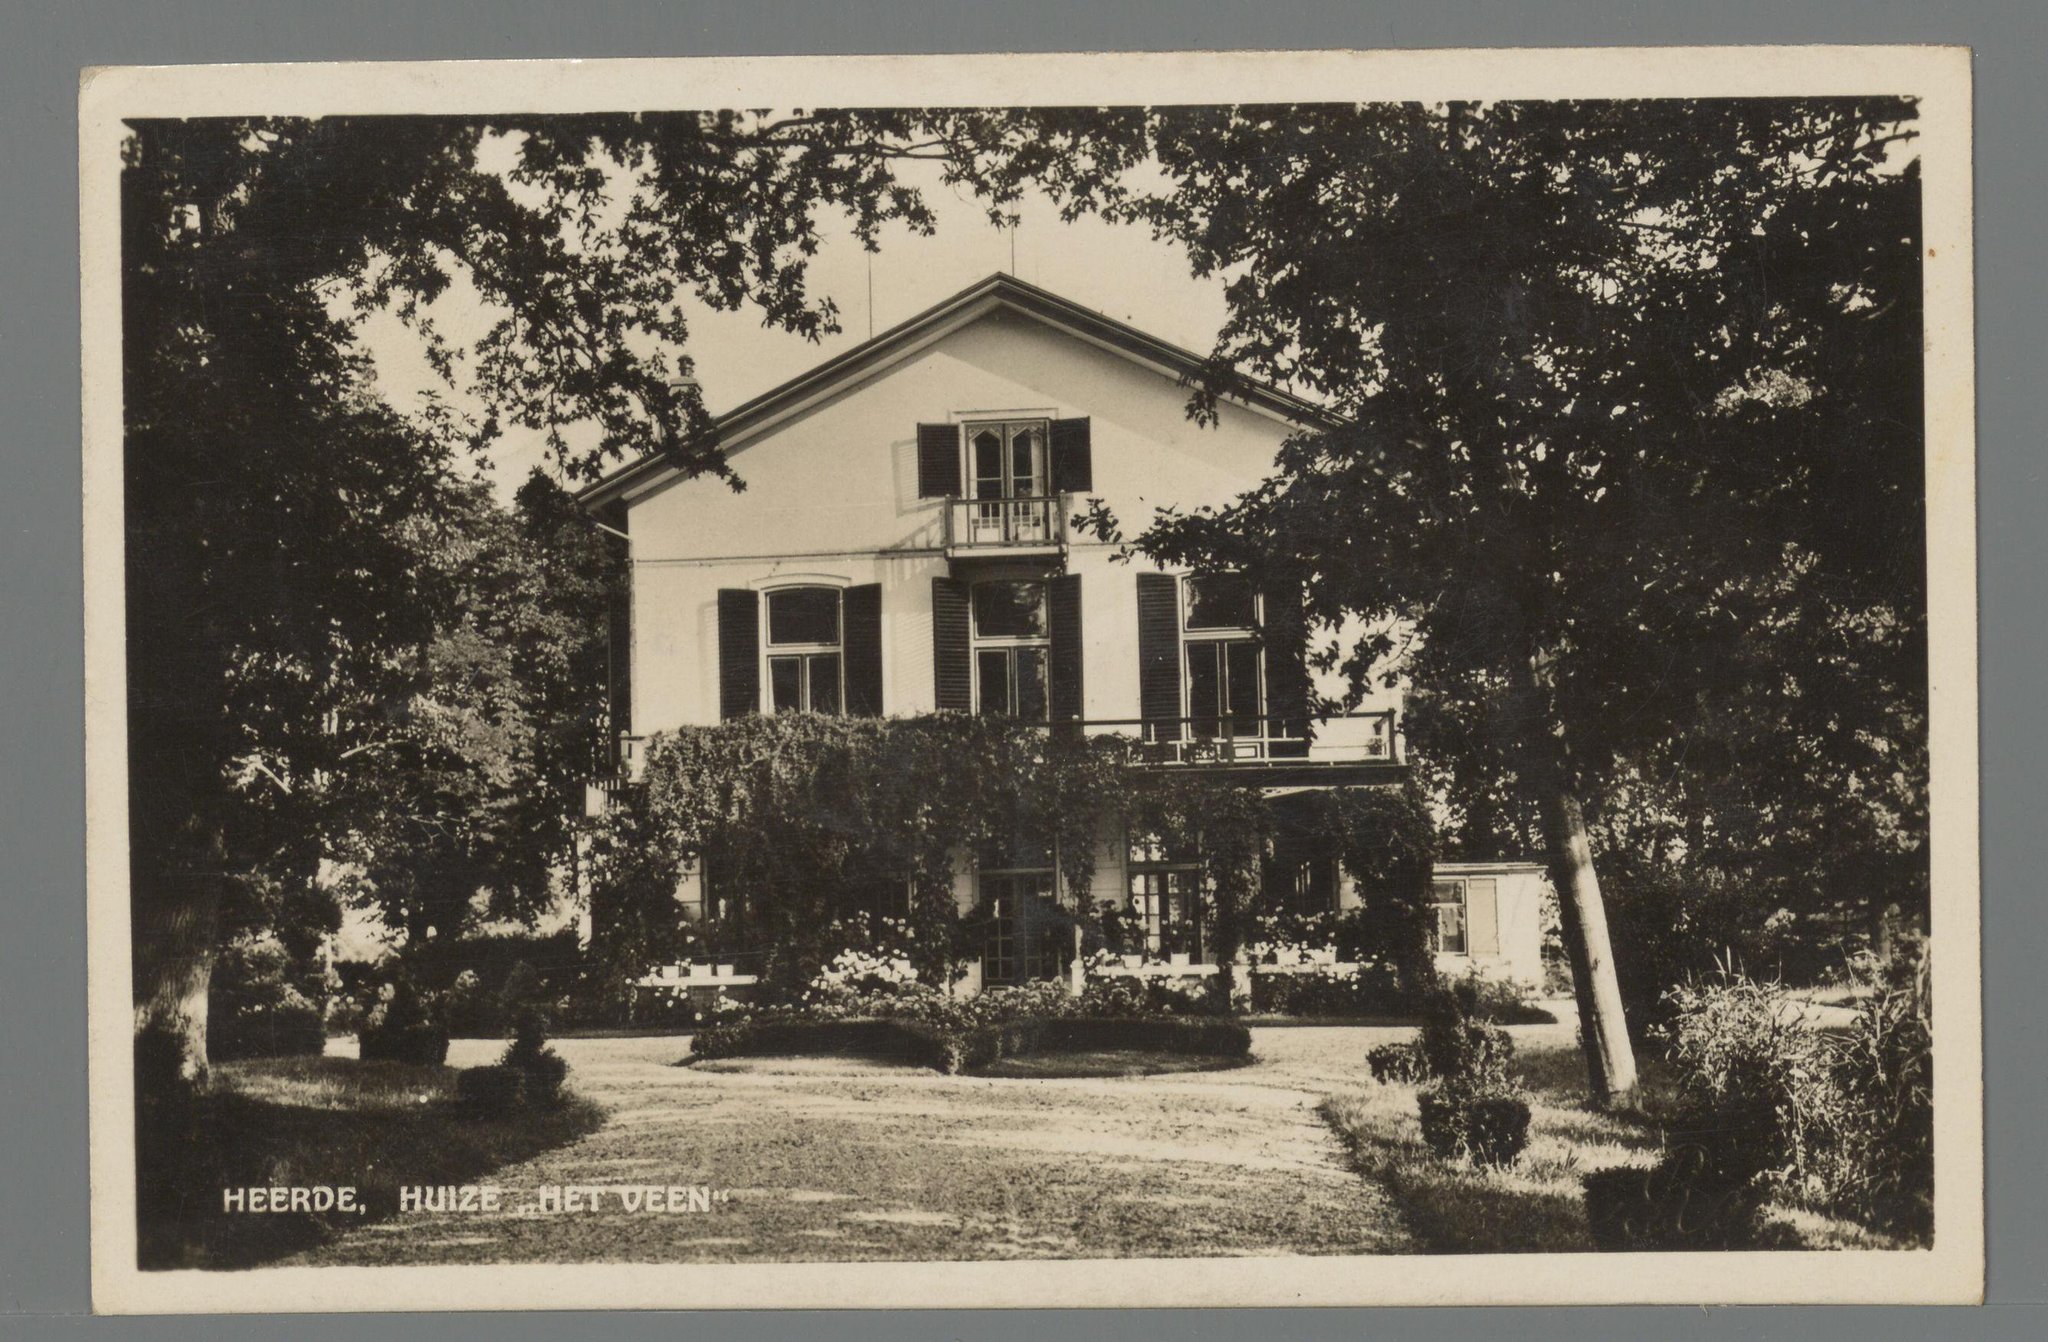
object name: photograph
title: Heerde, Huize "Het Veen"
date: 1929-1938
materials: paper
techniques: gelatin silver print, writing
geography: heerde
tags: villa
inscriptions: postage stamp